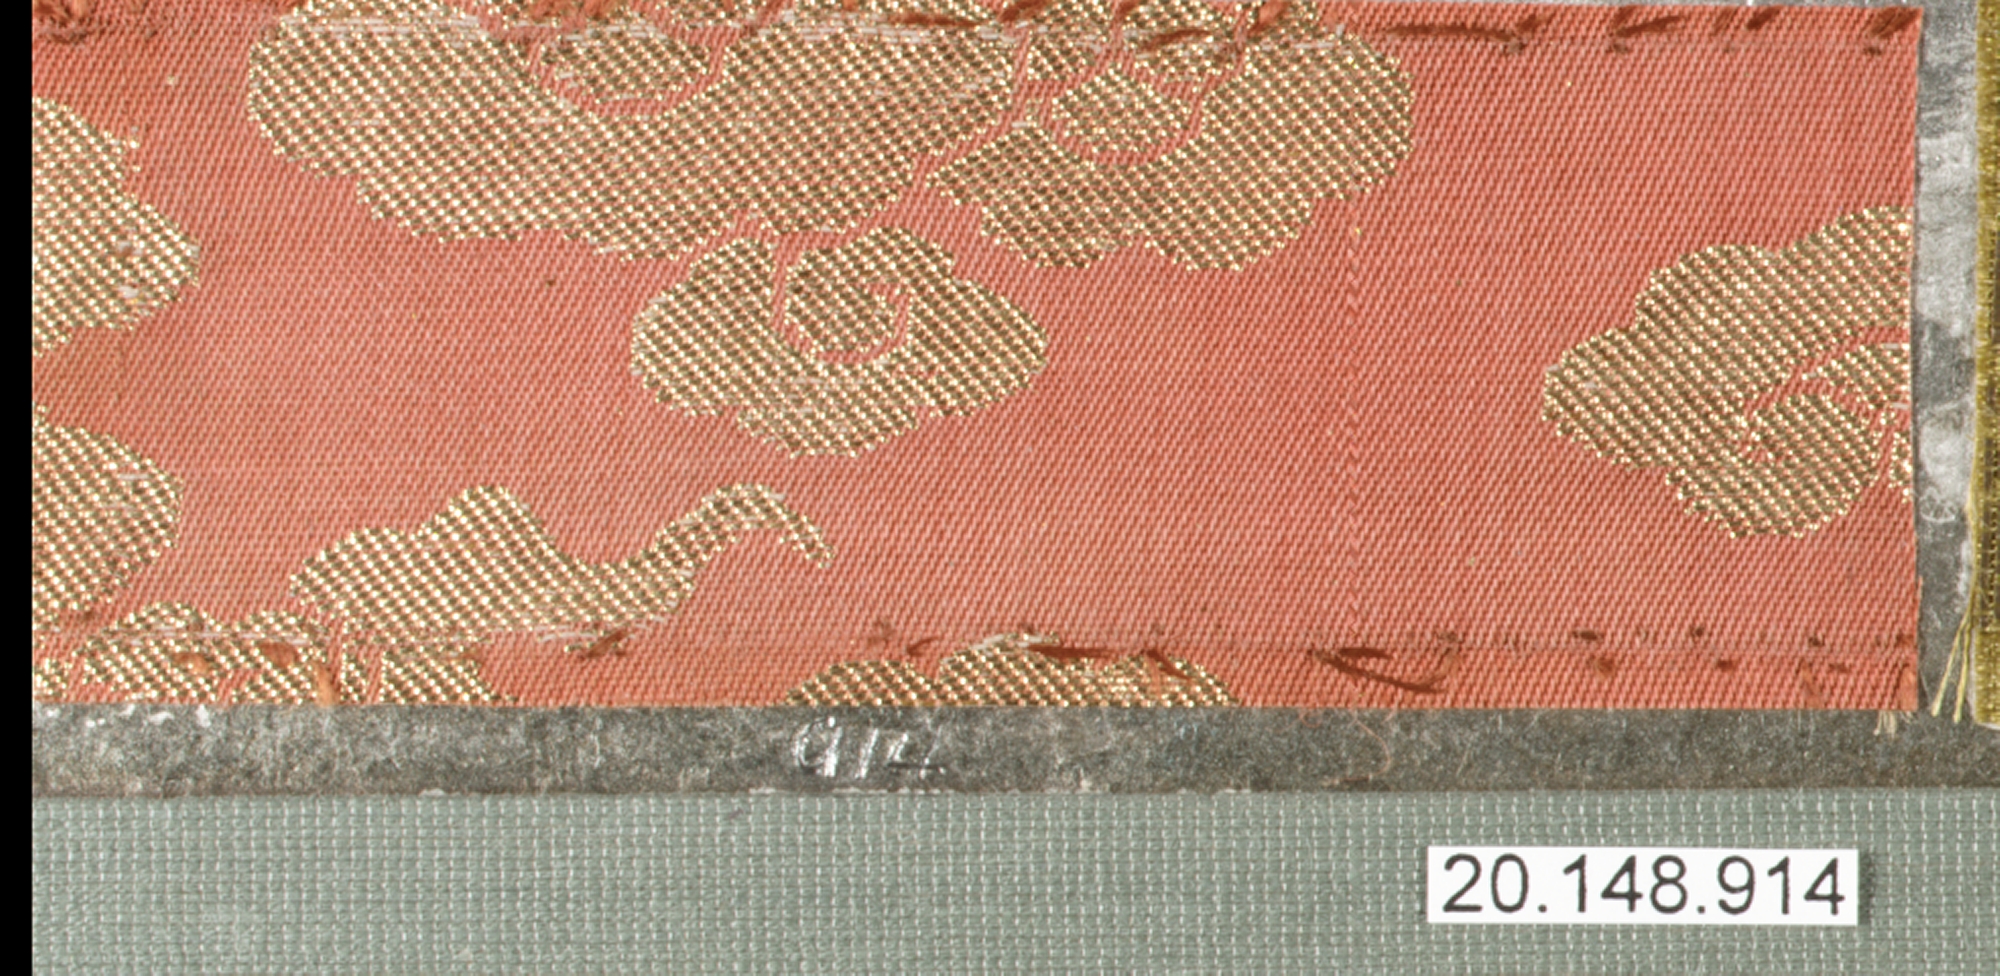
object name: piece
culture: japanese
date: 1701-1800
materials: silk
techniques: compound weave